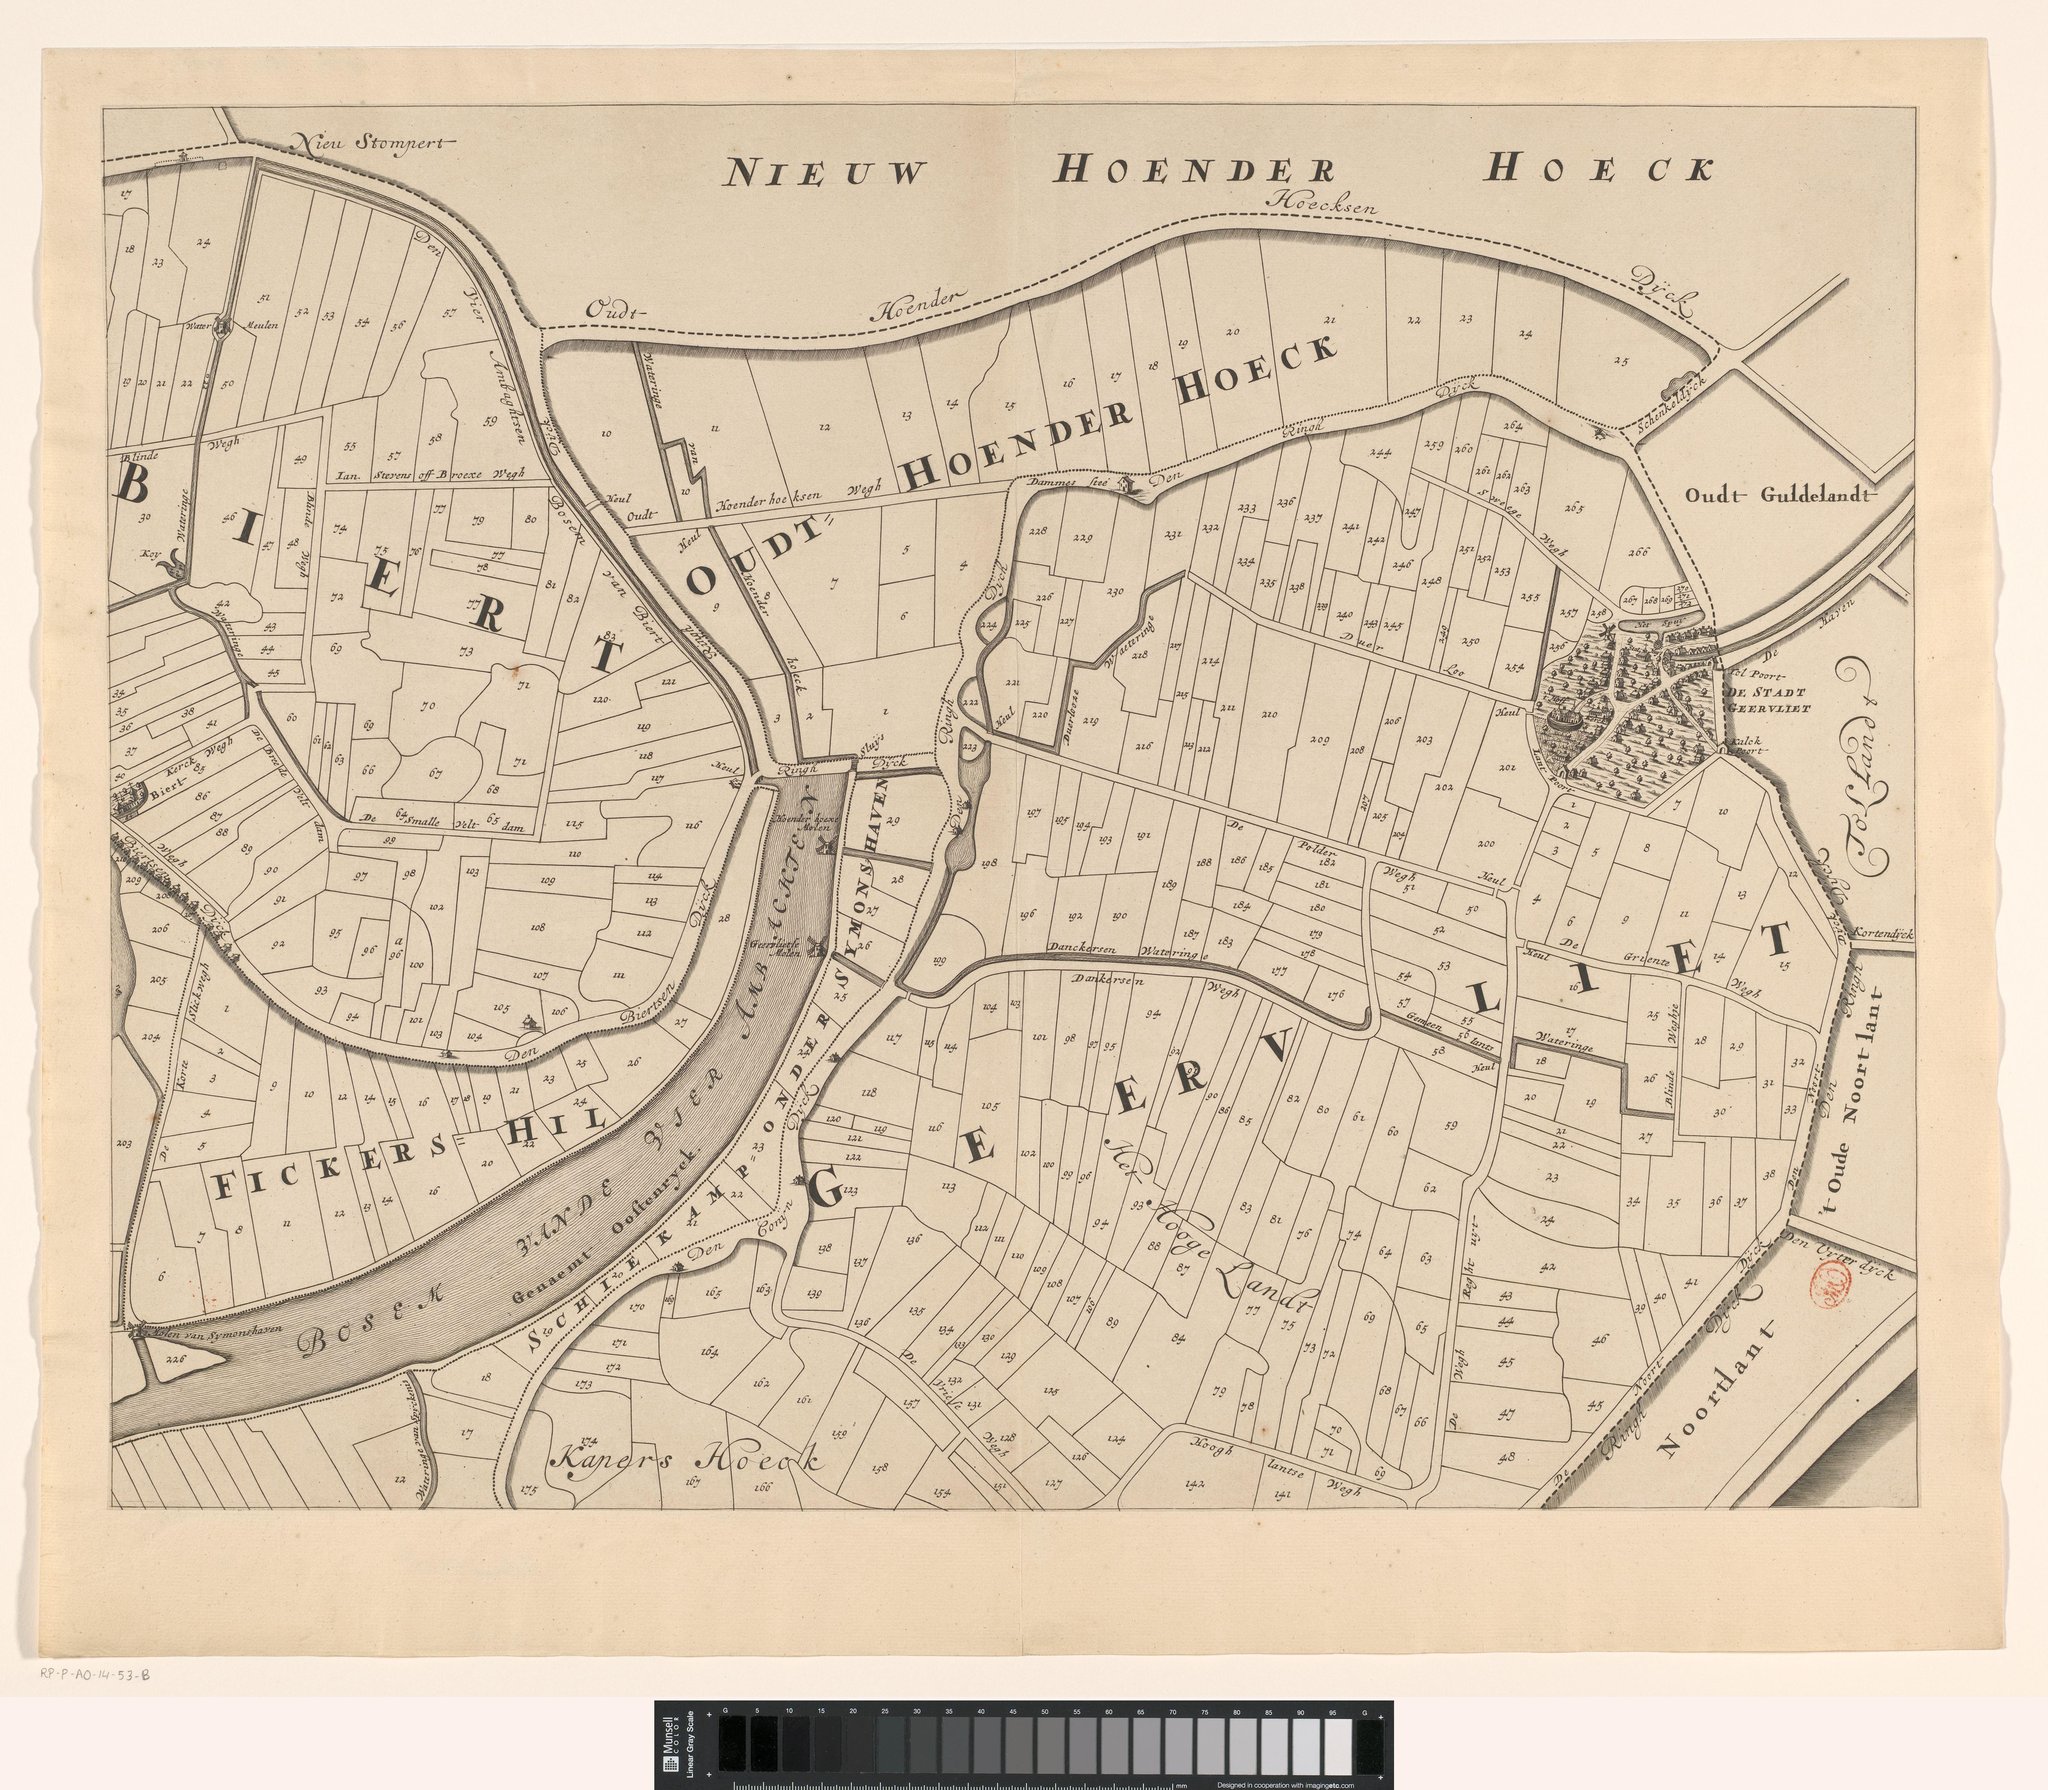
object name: map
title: Caerte gemaeckt op ordre vande bovengenoemde heeren opperdijckgraeff en hoog heemraden des Ringhs van Putten (…)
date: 1701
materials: paper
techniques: engraving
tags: maps of separate countries or regions, polder, reclaimed land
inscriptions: collector's mark: Lugt 195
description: Voor zover bekend is de kaart waar deze prent deel van is drie keer gedrukt; in 1701, 1738 en 1774. De huidige prent is onderdeel van de eerste druk. Waarschijnlijk verscheen de eerste druk (1701) zonder wapens van de opperdijkgraaf, secretaris en hoogheemraden. Voor de tweede druk (1738) werden de vier platen van de kaart bijgewerkt waardoor van elke plaat een tweede staat ontstond. Ook werd langs de bovenkant een wapenrand (gedrukt van één plaat) en langs de zijkanten een sierrand (gedrukt van twee platen) toegevoegd. Het bestuur bestond destijds uit opperdijkgraaf Gualterus de Raet, secretaris Nicolaas Hooreman en hoogheemraden Dirck Lieve, Cornelis Taal, Adriaen Roosmael, Pieter van der Mersch en Johannes Assuerus Roosendael. Zie RP-P-AO-14-53A voor een exemplaar van de tweede druk/staat (zonder sierrand). Voor de derde druk (1774) werd in ieder geval de plaat rechtsonder bijgewerkt. Verder onderzoek is nodig om vast te stellen of de drie andere platen van de kaart ook werden bijgewerkt. Het bestuur bestond destijds uit opperdijkgraaf Dirk Bouwens, secretaris Carel Willem Hogerwaard en hoogheemraden Joh. van der Zaag, Hendrik Hoogendyck, Jan Jacob Villerius, Dammis Hoogendyck en Paulus Gevers.